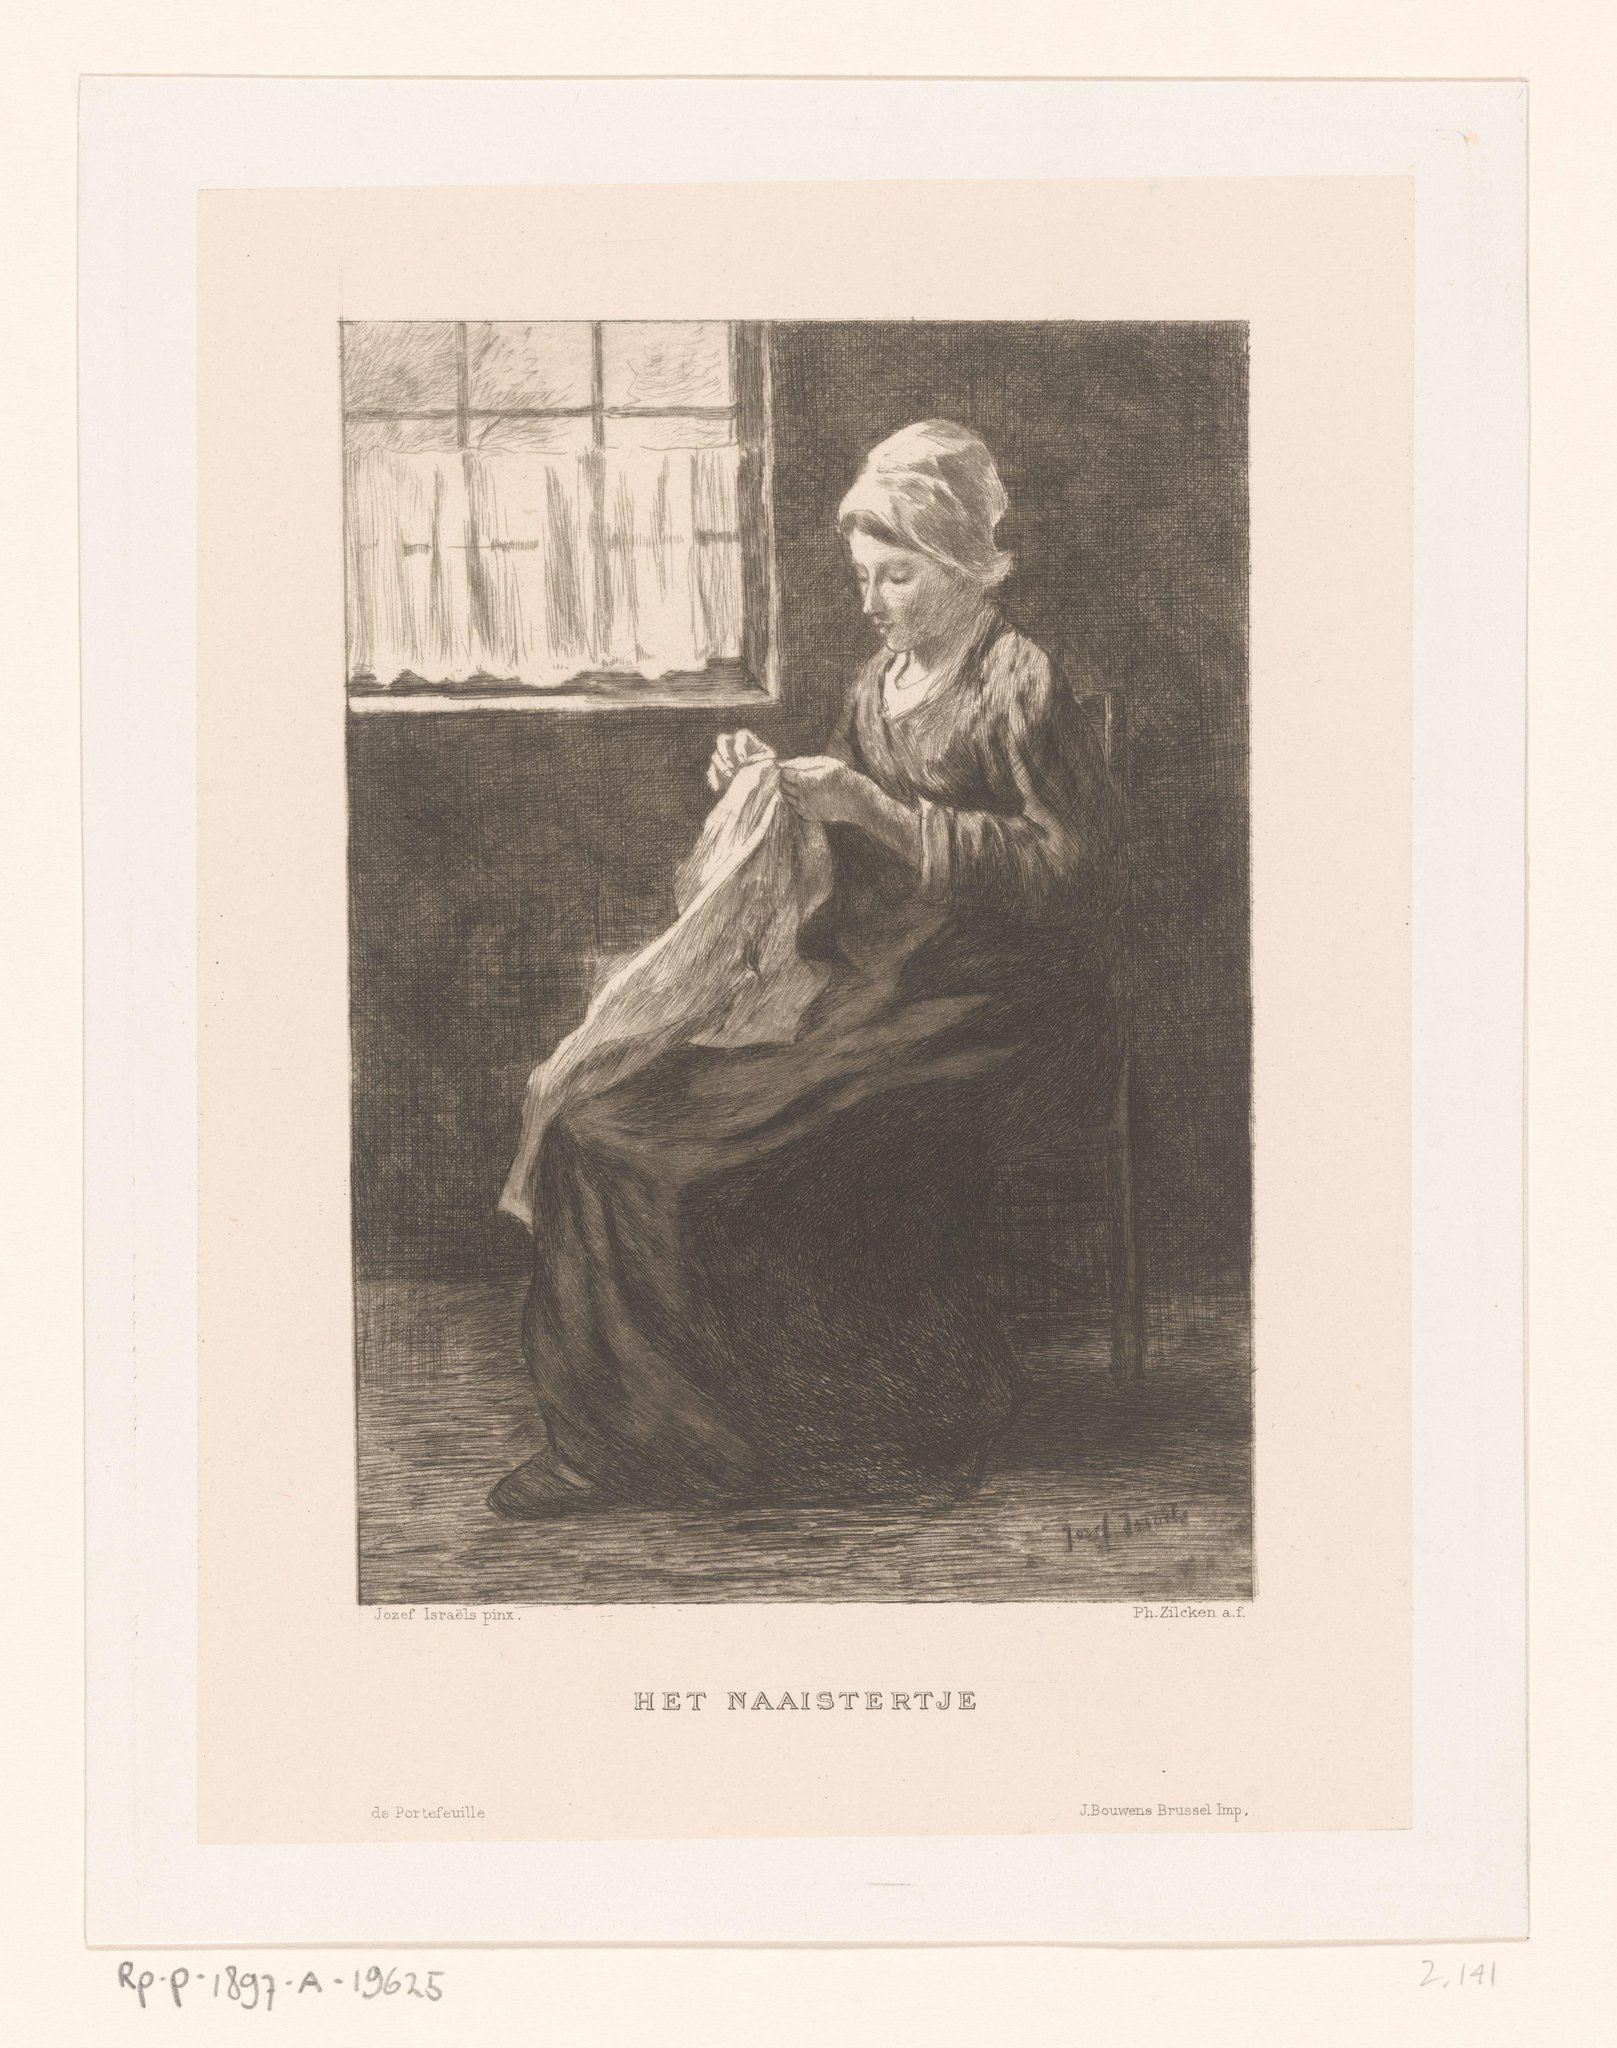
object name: print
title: The Little Seamstress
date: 1880-1890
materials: paper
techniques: drypoint, etching, intaglio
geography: brussels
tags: adult woman, sewing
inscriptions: collector's mark: Lugt 2228